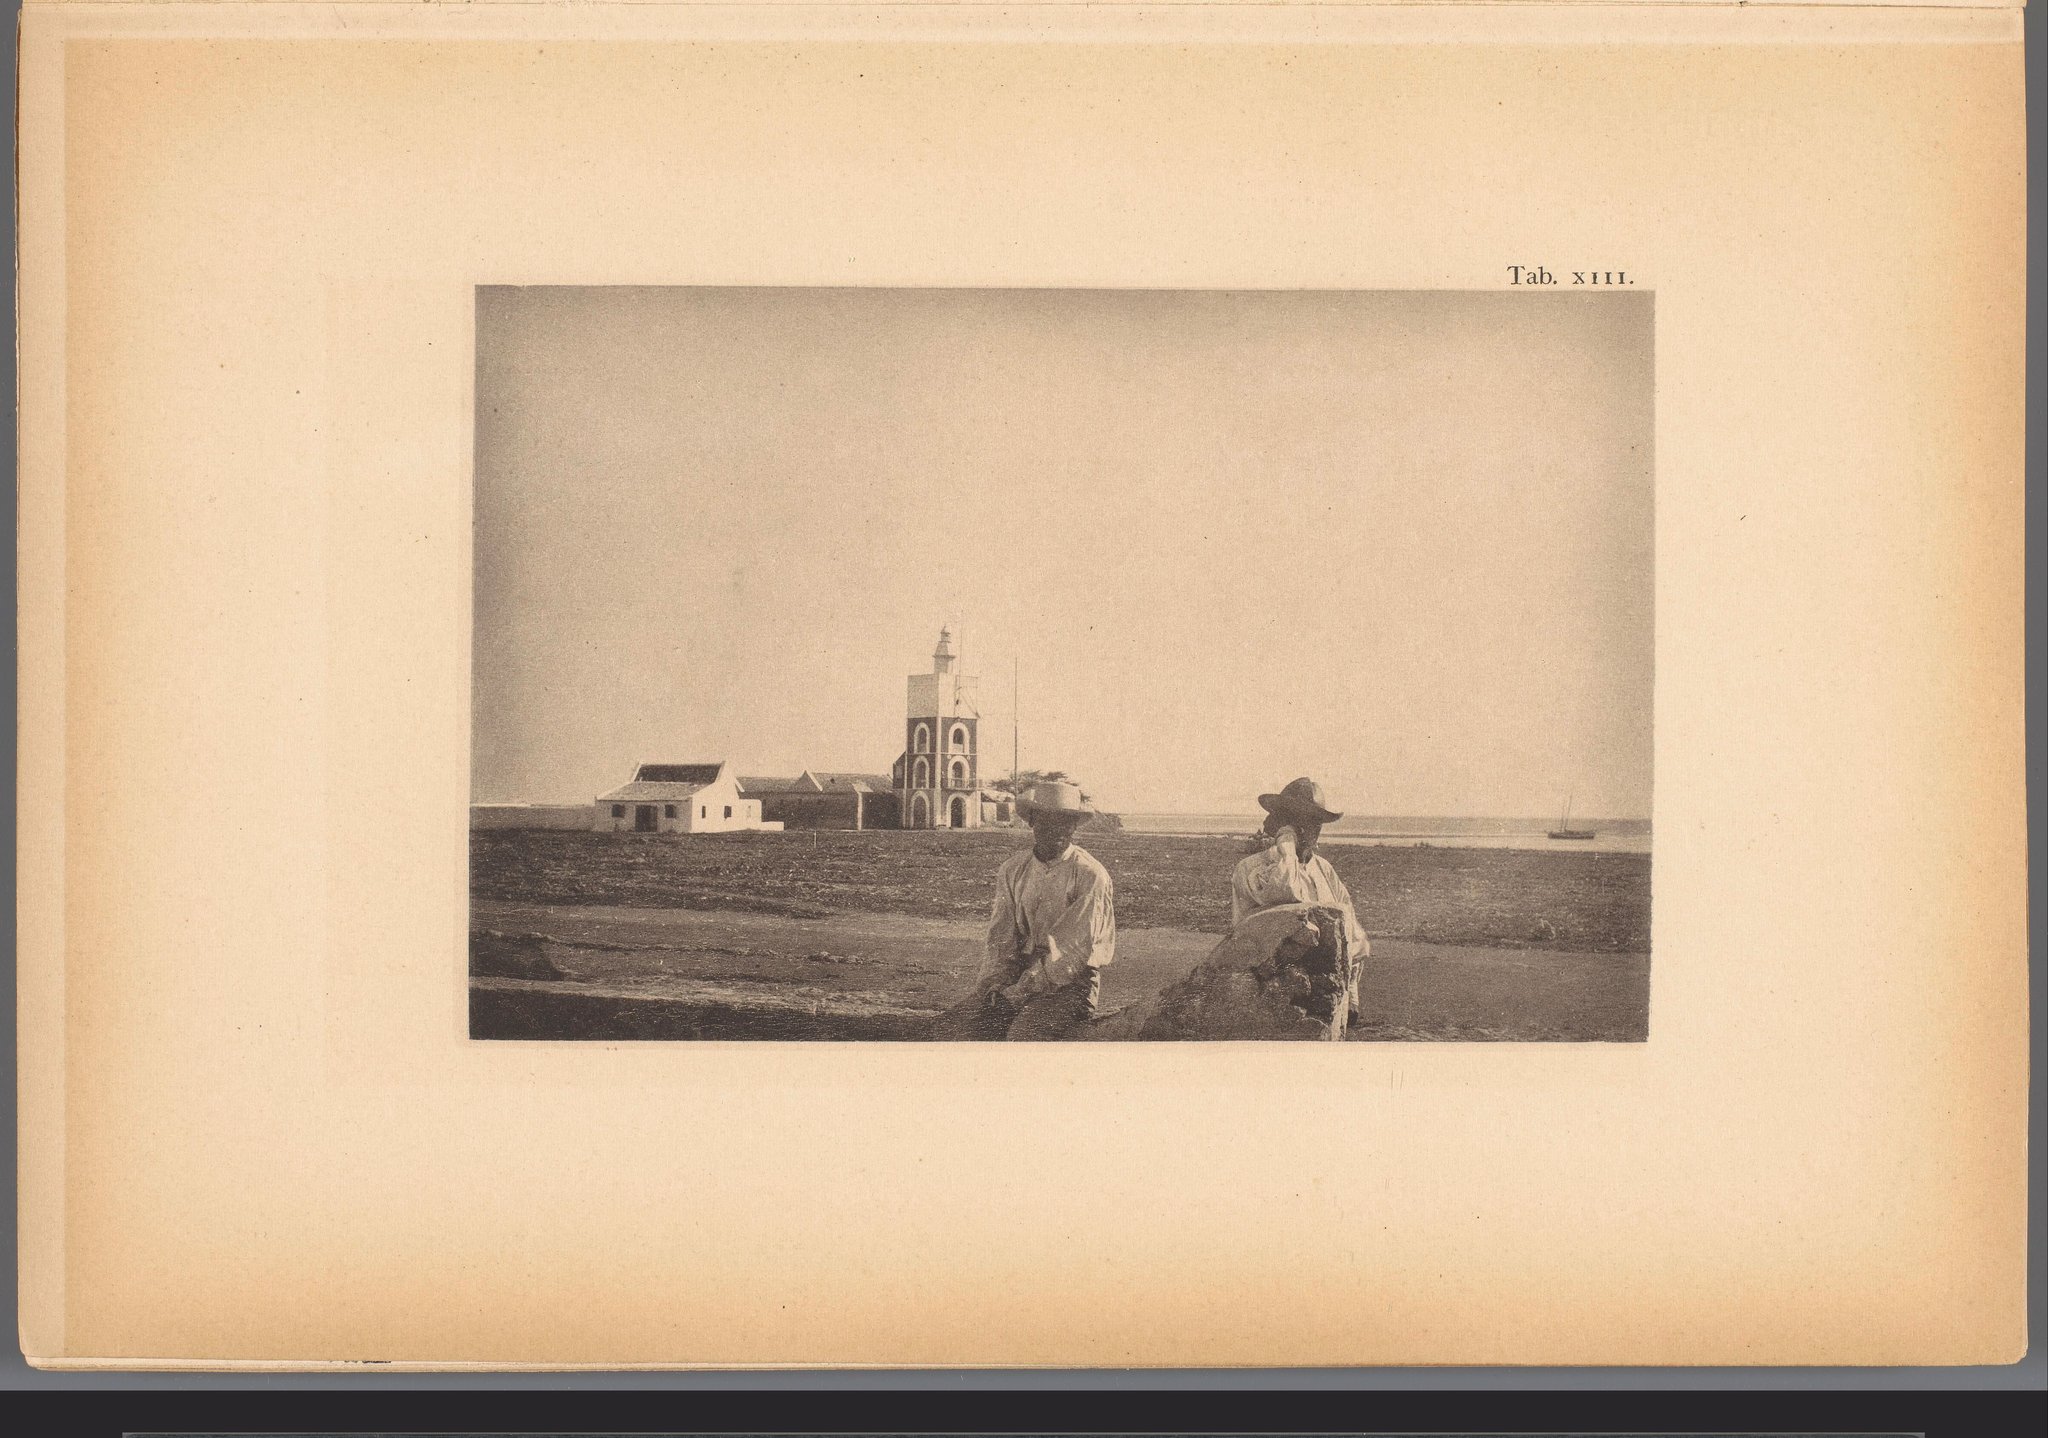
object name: page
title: Gezicht op Fort Zoutman in Oranjestad op Aruba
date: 1877-1887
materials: paper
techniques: photograph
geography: oranjestad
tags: fortress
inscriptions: number: ‘Tab. XIII.’